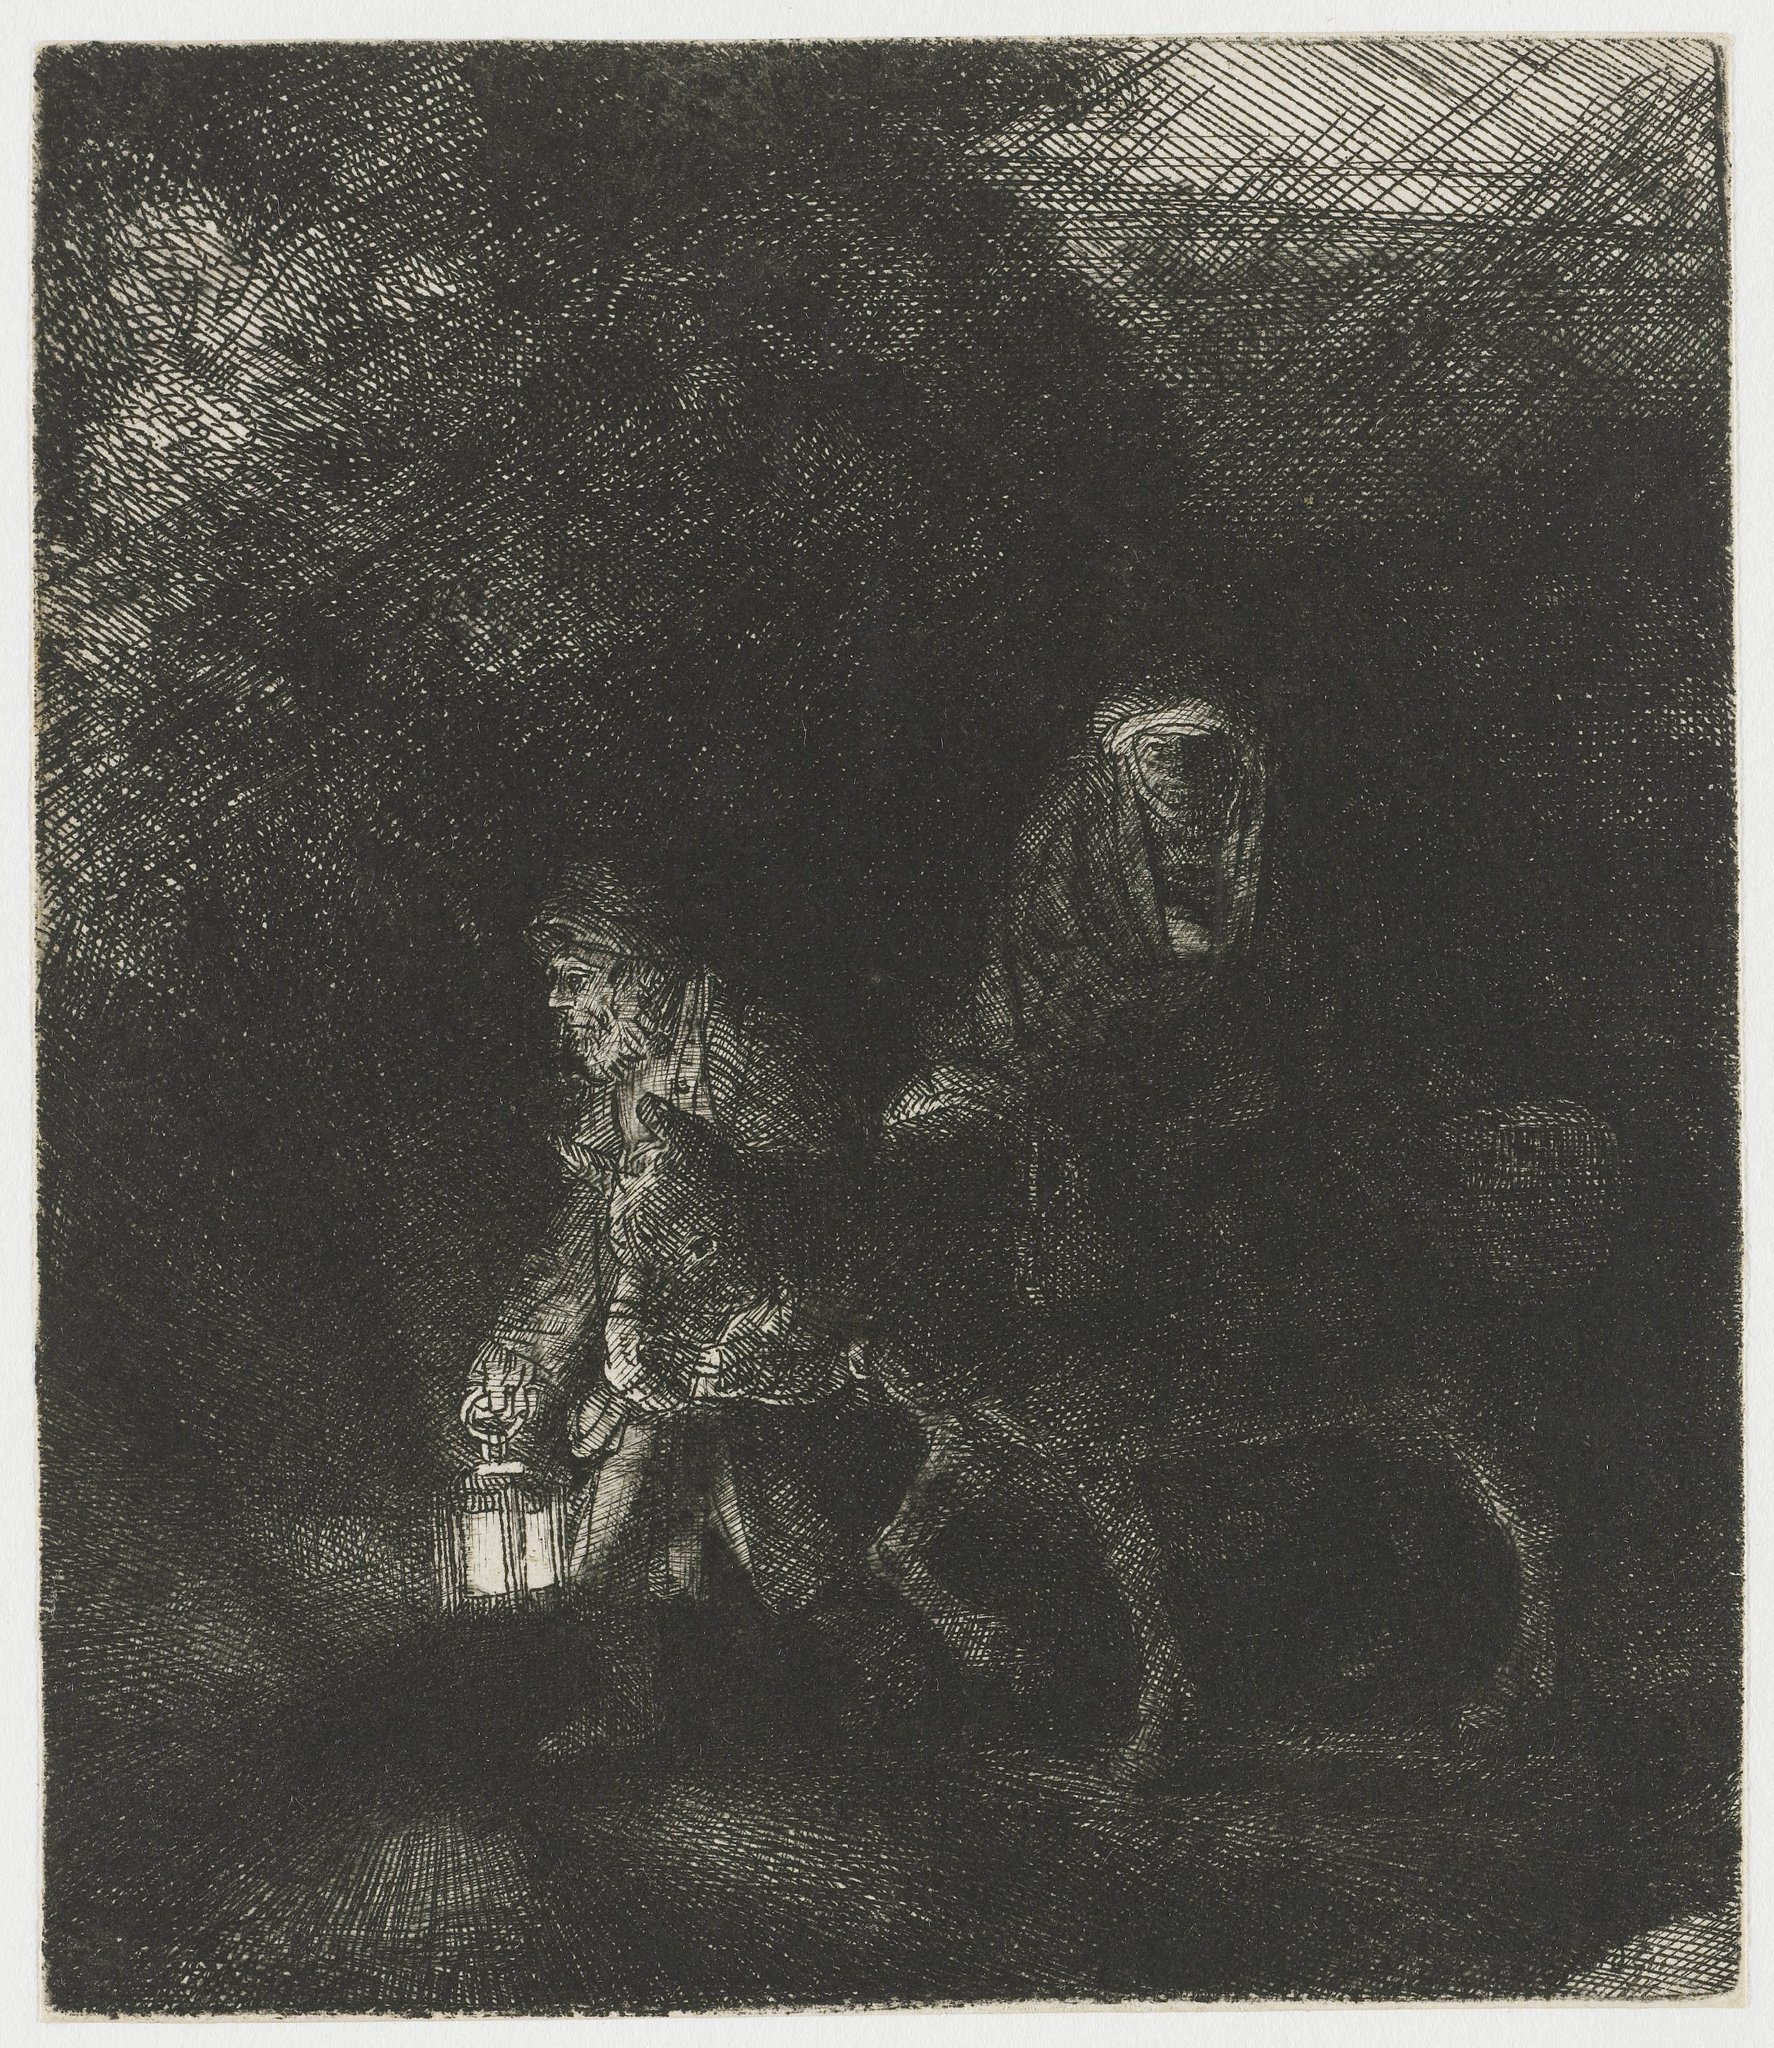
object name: print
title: The flight into Egypt: a night piece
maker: rembrandt van rijn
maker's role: draughtsman, painter, print maker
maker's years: 1606-1669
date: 1651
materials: paper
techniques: drypoint, etching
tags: the flight into egypt: mary, joseph, the child (and sometimes others) on their way; mary usually riding on an ass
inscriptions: signature and date: ‘Rembrandt f. 1651’, collector's mark: Lugt 240